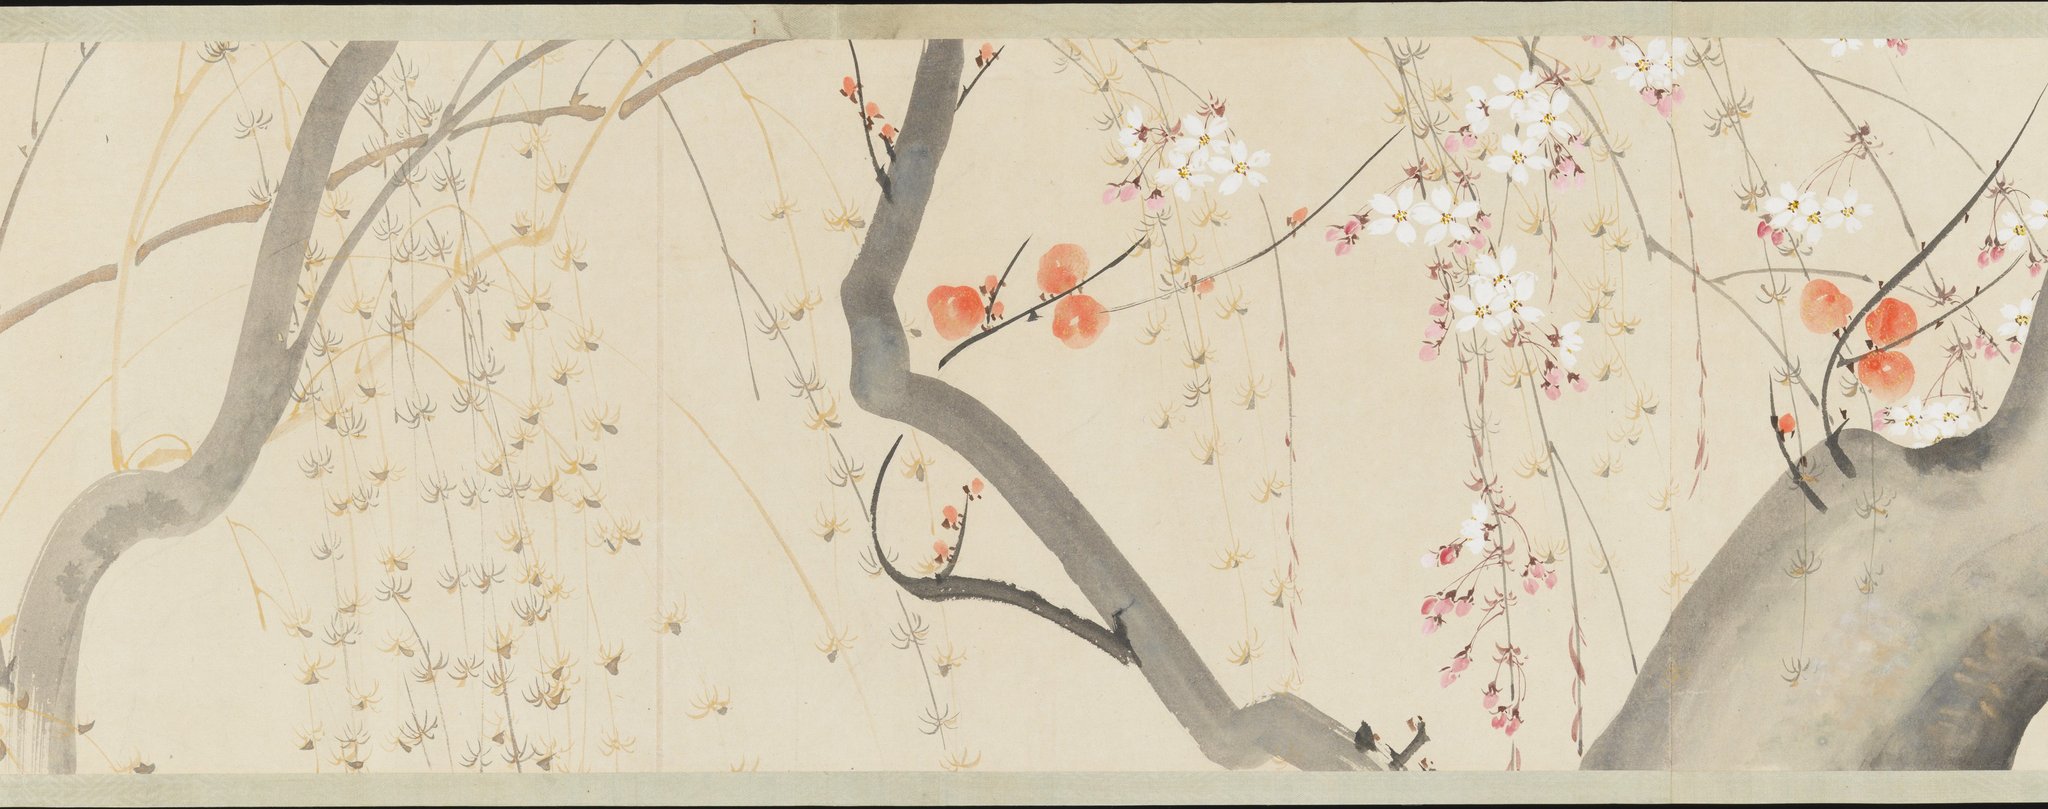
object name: handscroll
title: Flowers of the Four Seasons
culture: japanese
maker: sakai hōitsu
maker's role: artist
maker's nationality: japanese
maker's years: 1761-1828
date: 1815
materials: ink, paper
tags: flowers